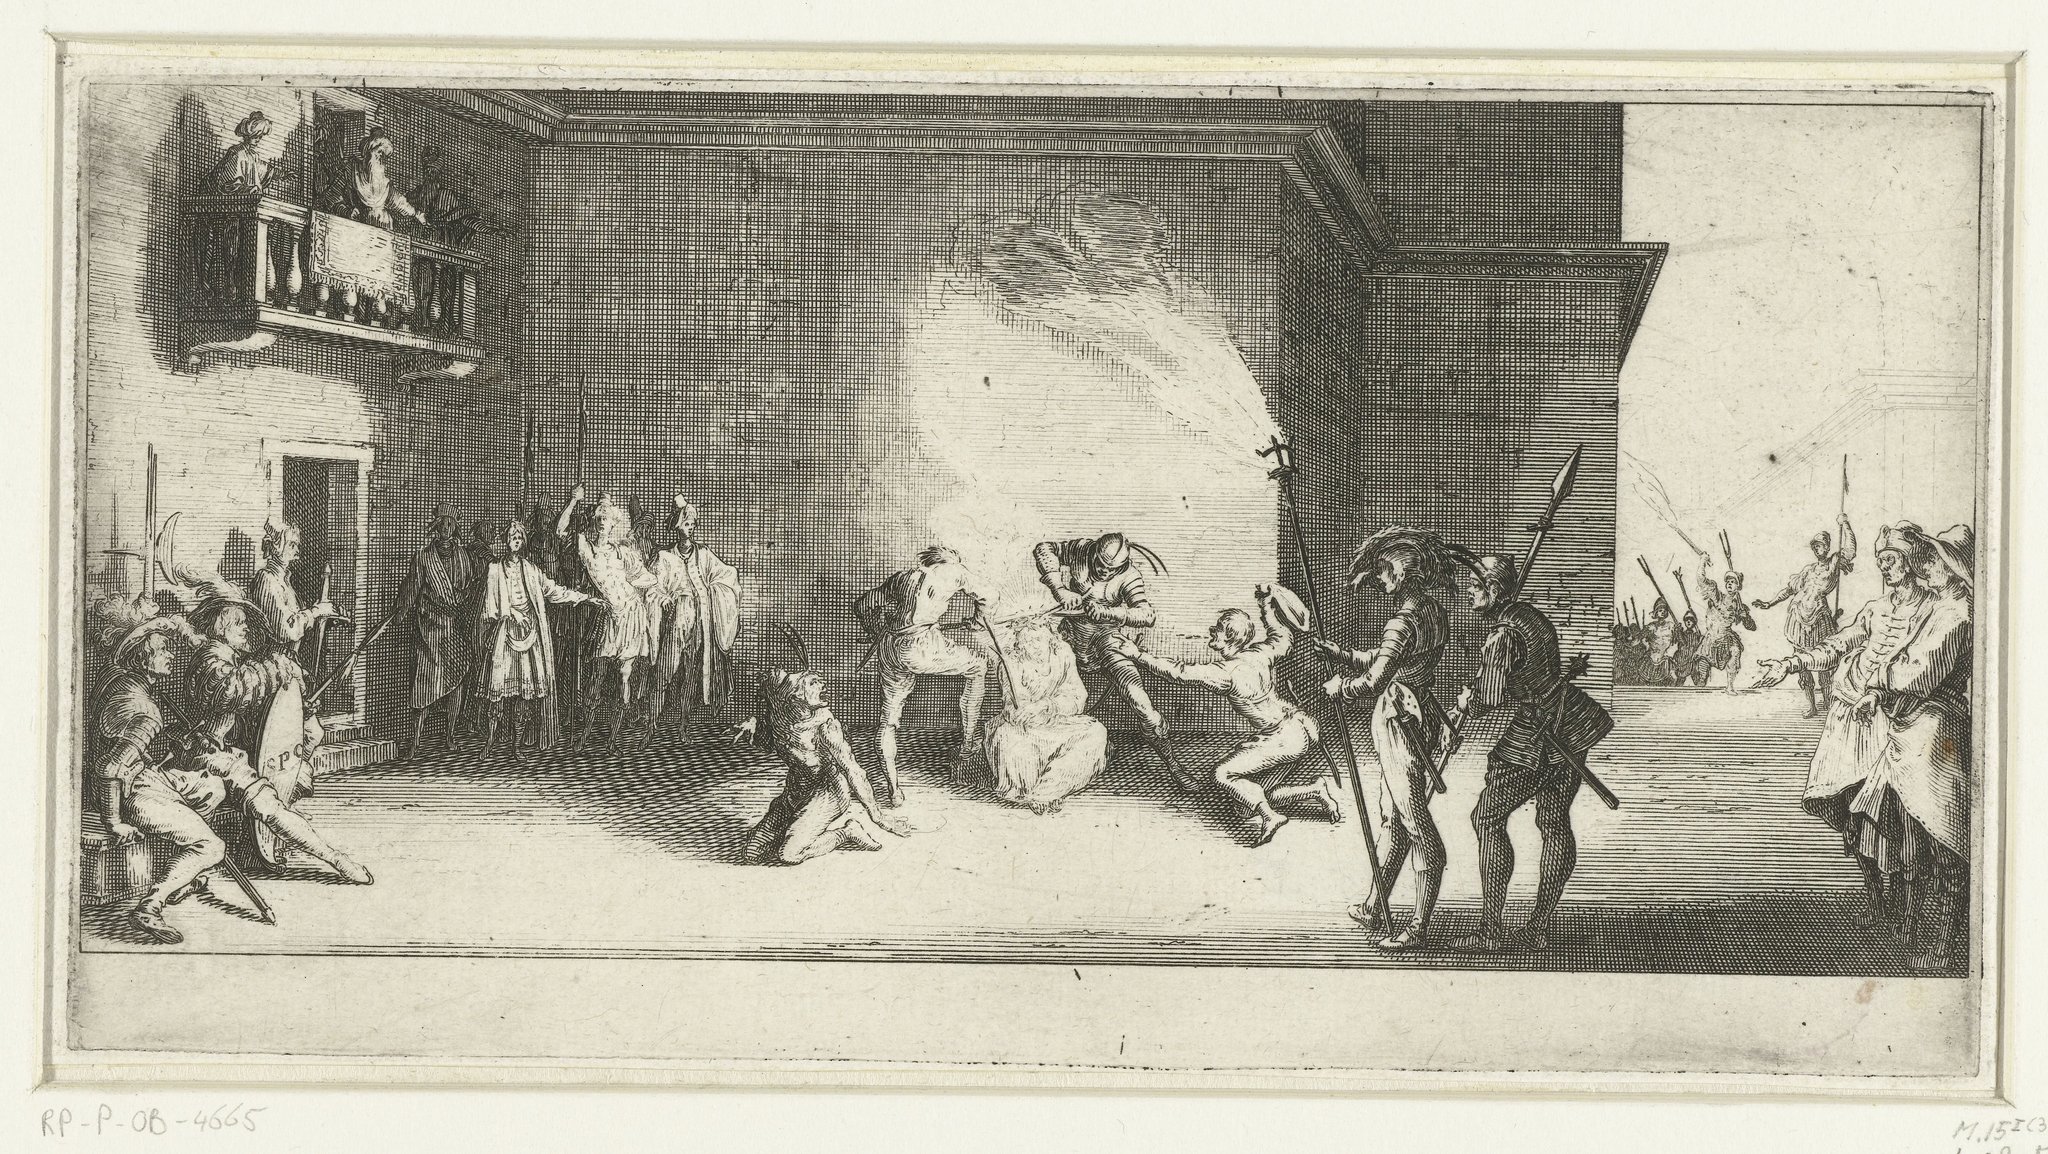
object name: print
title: De grote Passie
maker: jacques callot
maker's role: draughtsman, print maker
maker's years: 1592-1635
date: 1619-1624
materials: paper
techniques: engraving, etching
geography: florence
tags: the crowning with thorns: soldiers with sticks place a thorny crown on christ's head and give him a reed (matthew 27:27-31; mark 15:16-20; john 19:2-3)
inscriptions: collector's mark: Lugt 240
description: Soldaten duwen Christus, zittend voor een gebouw, een doornenkroon op het hoofd. Vanaf een balkon kijken drie mannen toe. Deze prent is onderdeel van de onvoltooide prentserie 'De grote Passie', bestaande uit 7 scènes uit het Lijdensverhaal.